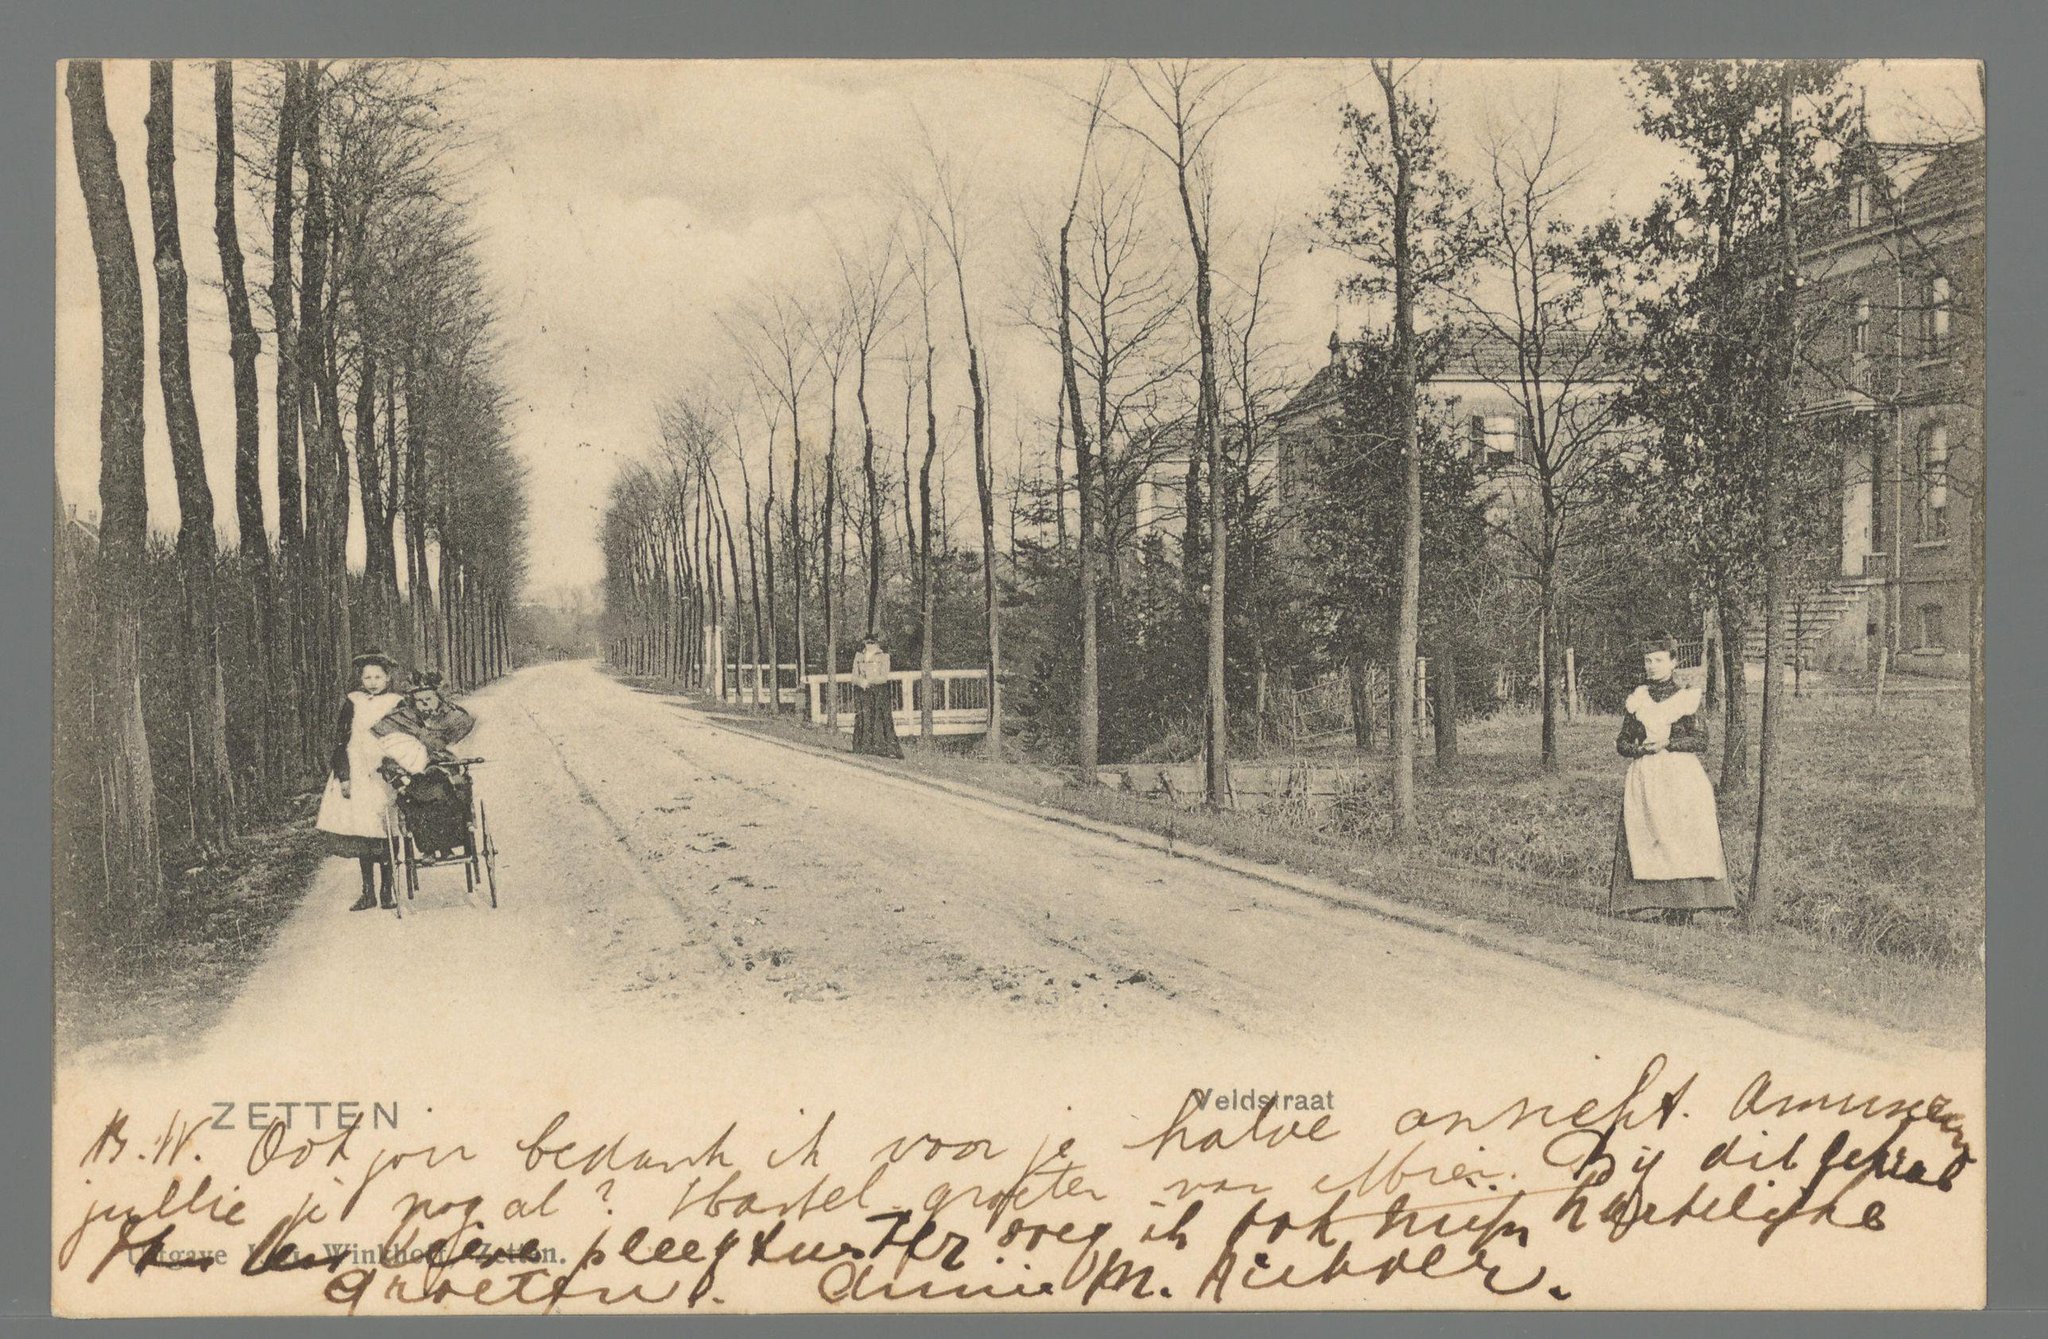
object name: photomechanical print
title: ZETTEN. Veldstraat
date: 1897-1905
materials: cardboard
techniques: photograph, writing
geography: zetten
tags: village street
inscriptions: postage stamp